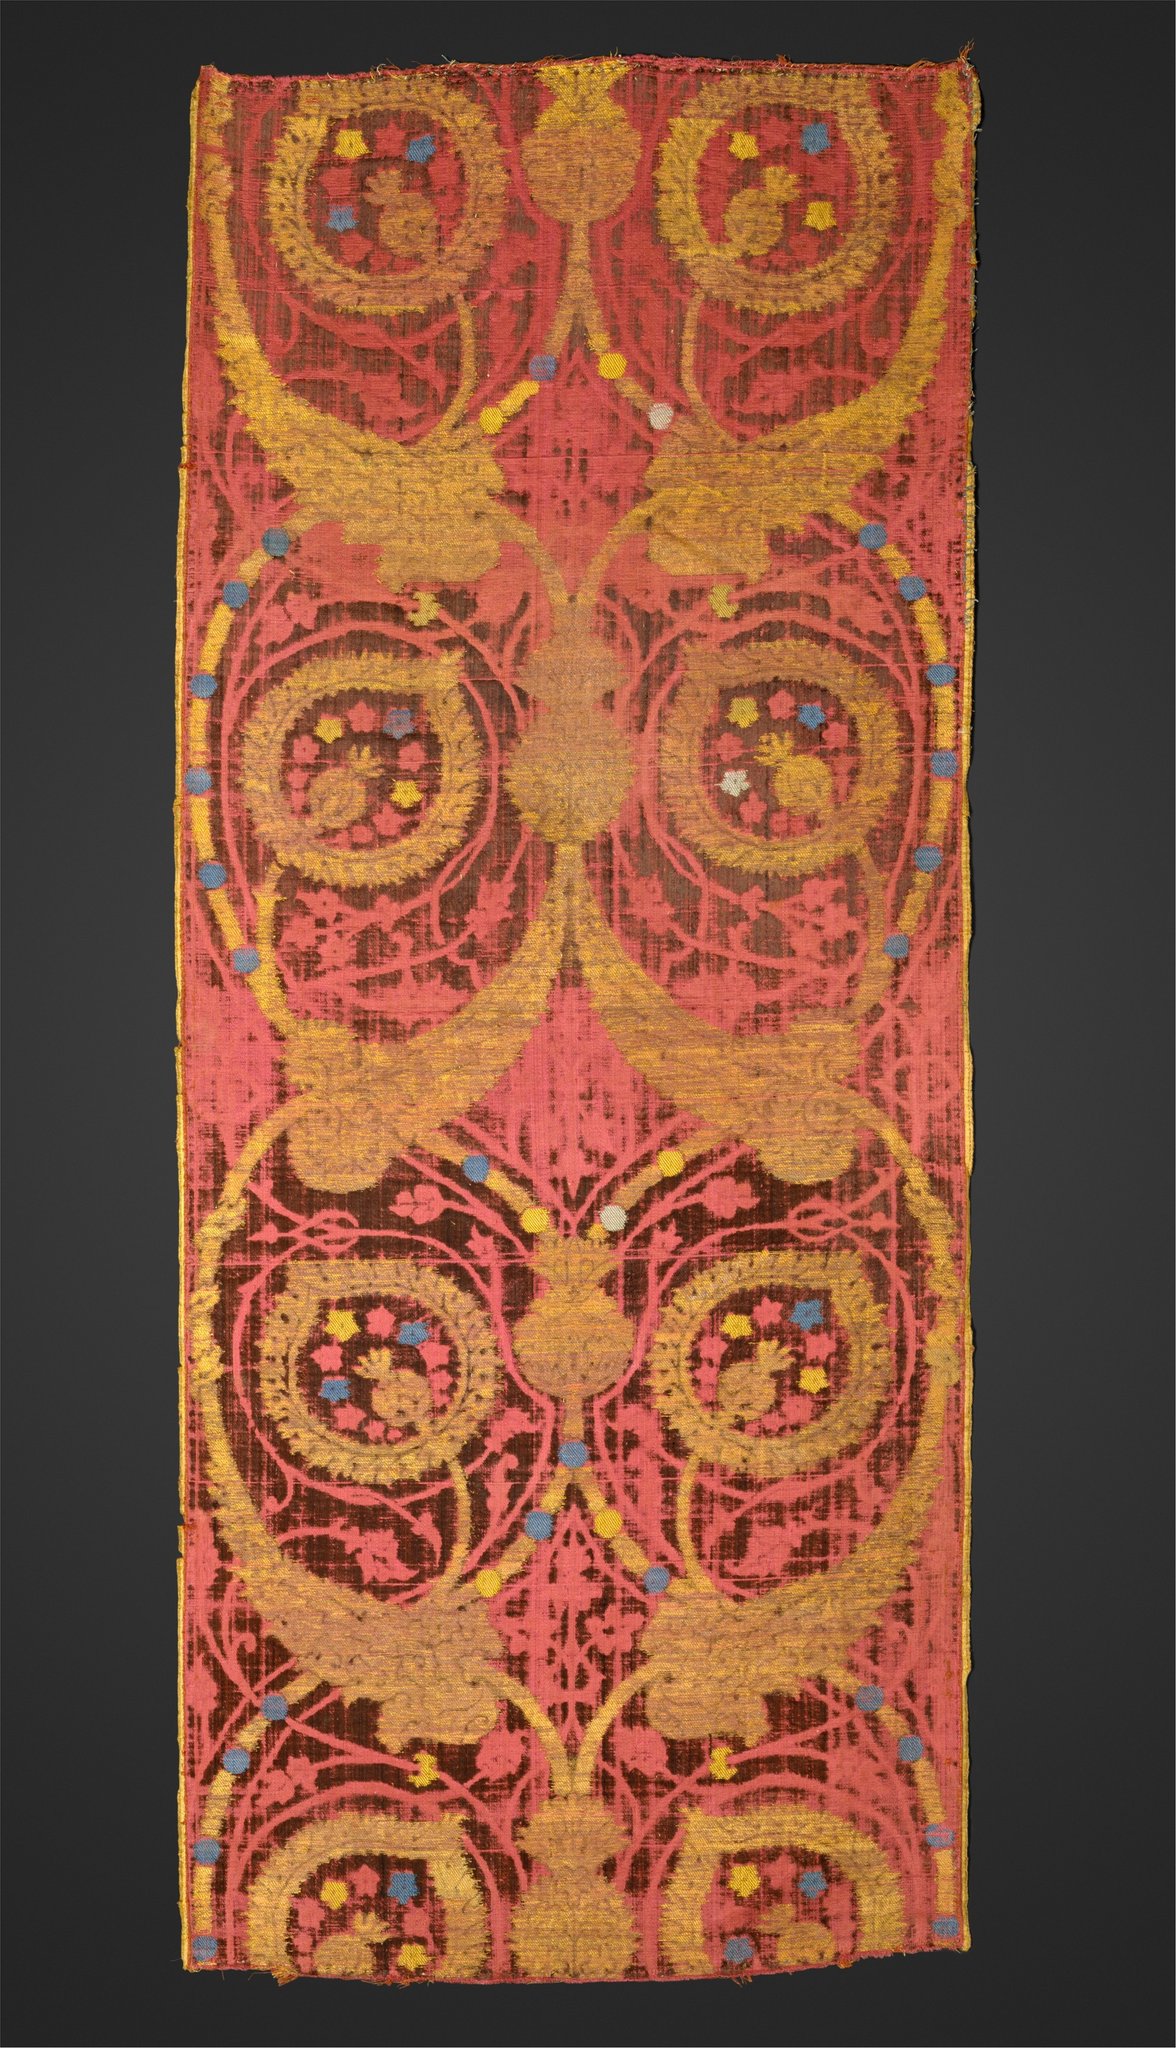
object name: textile fragment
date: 1601-1700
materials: metal thread, silk, velvet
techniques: brocade, voiding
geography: turkey